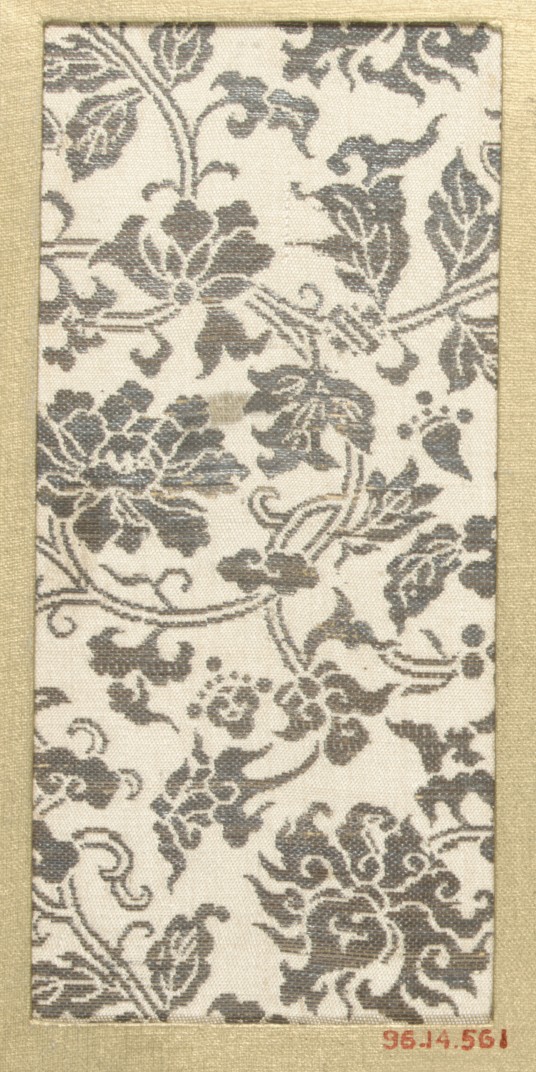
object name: piece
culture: japanese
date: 1701-1900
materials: silk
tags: leaves